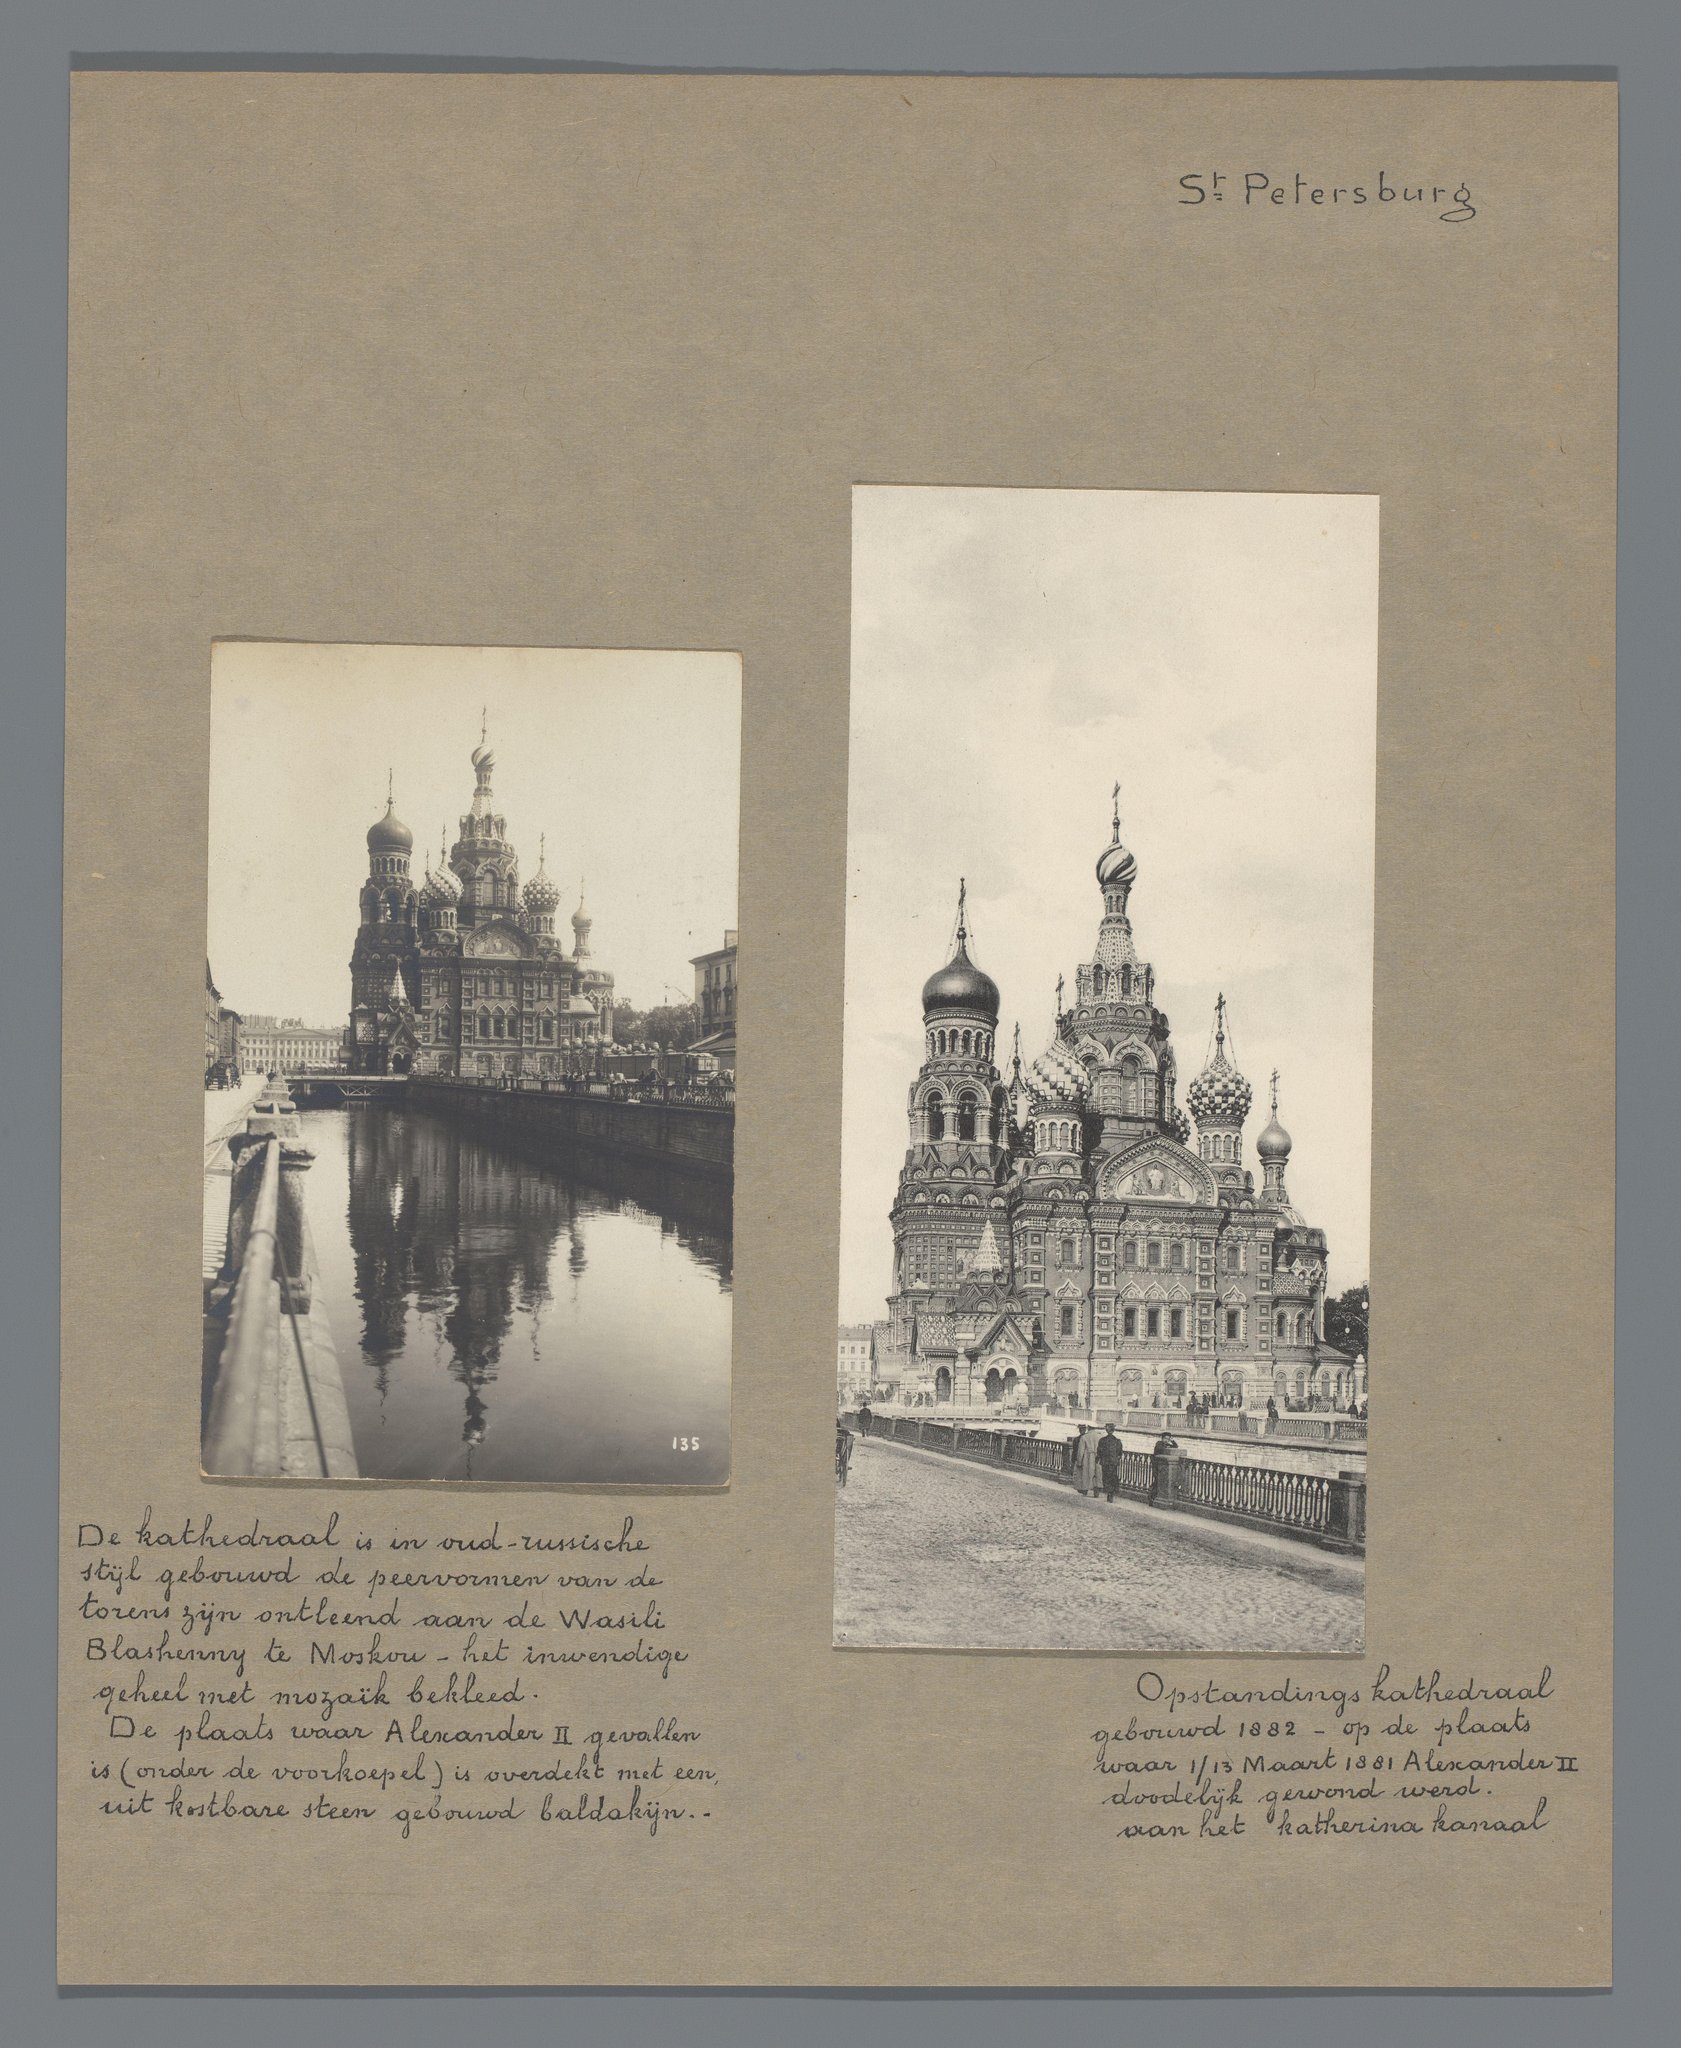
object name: photograph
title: St. Petersburg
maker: Anonymous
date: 1860-1925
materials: photographic support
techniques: photograph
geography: russia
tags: sint-petersburg